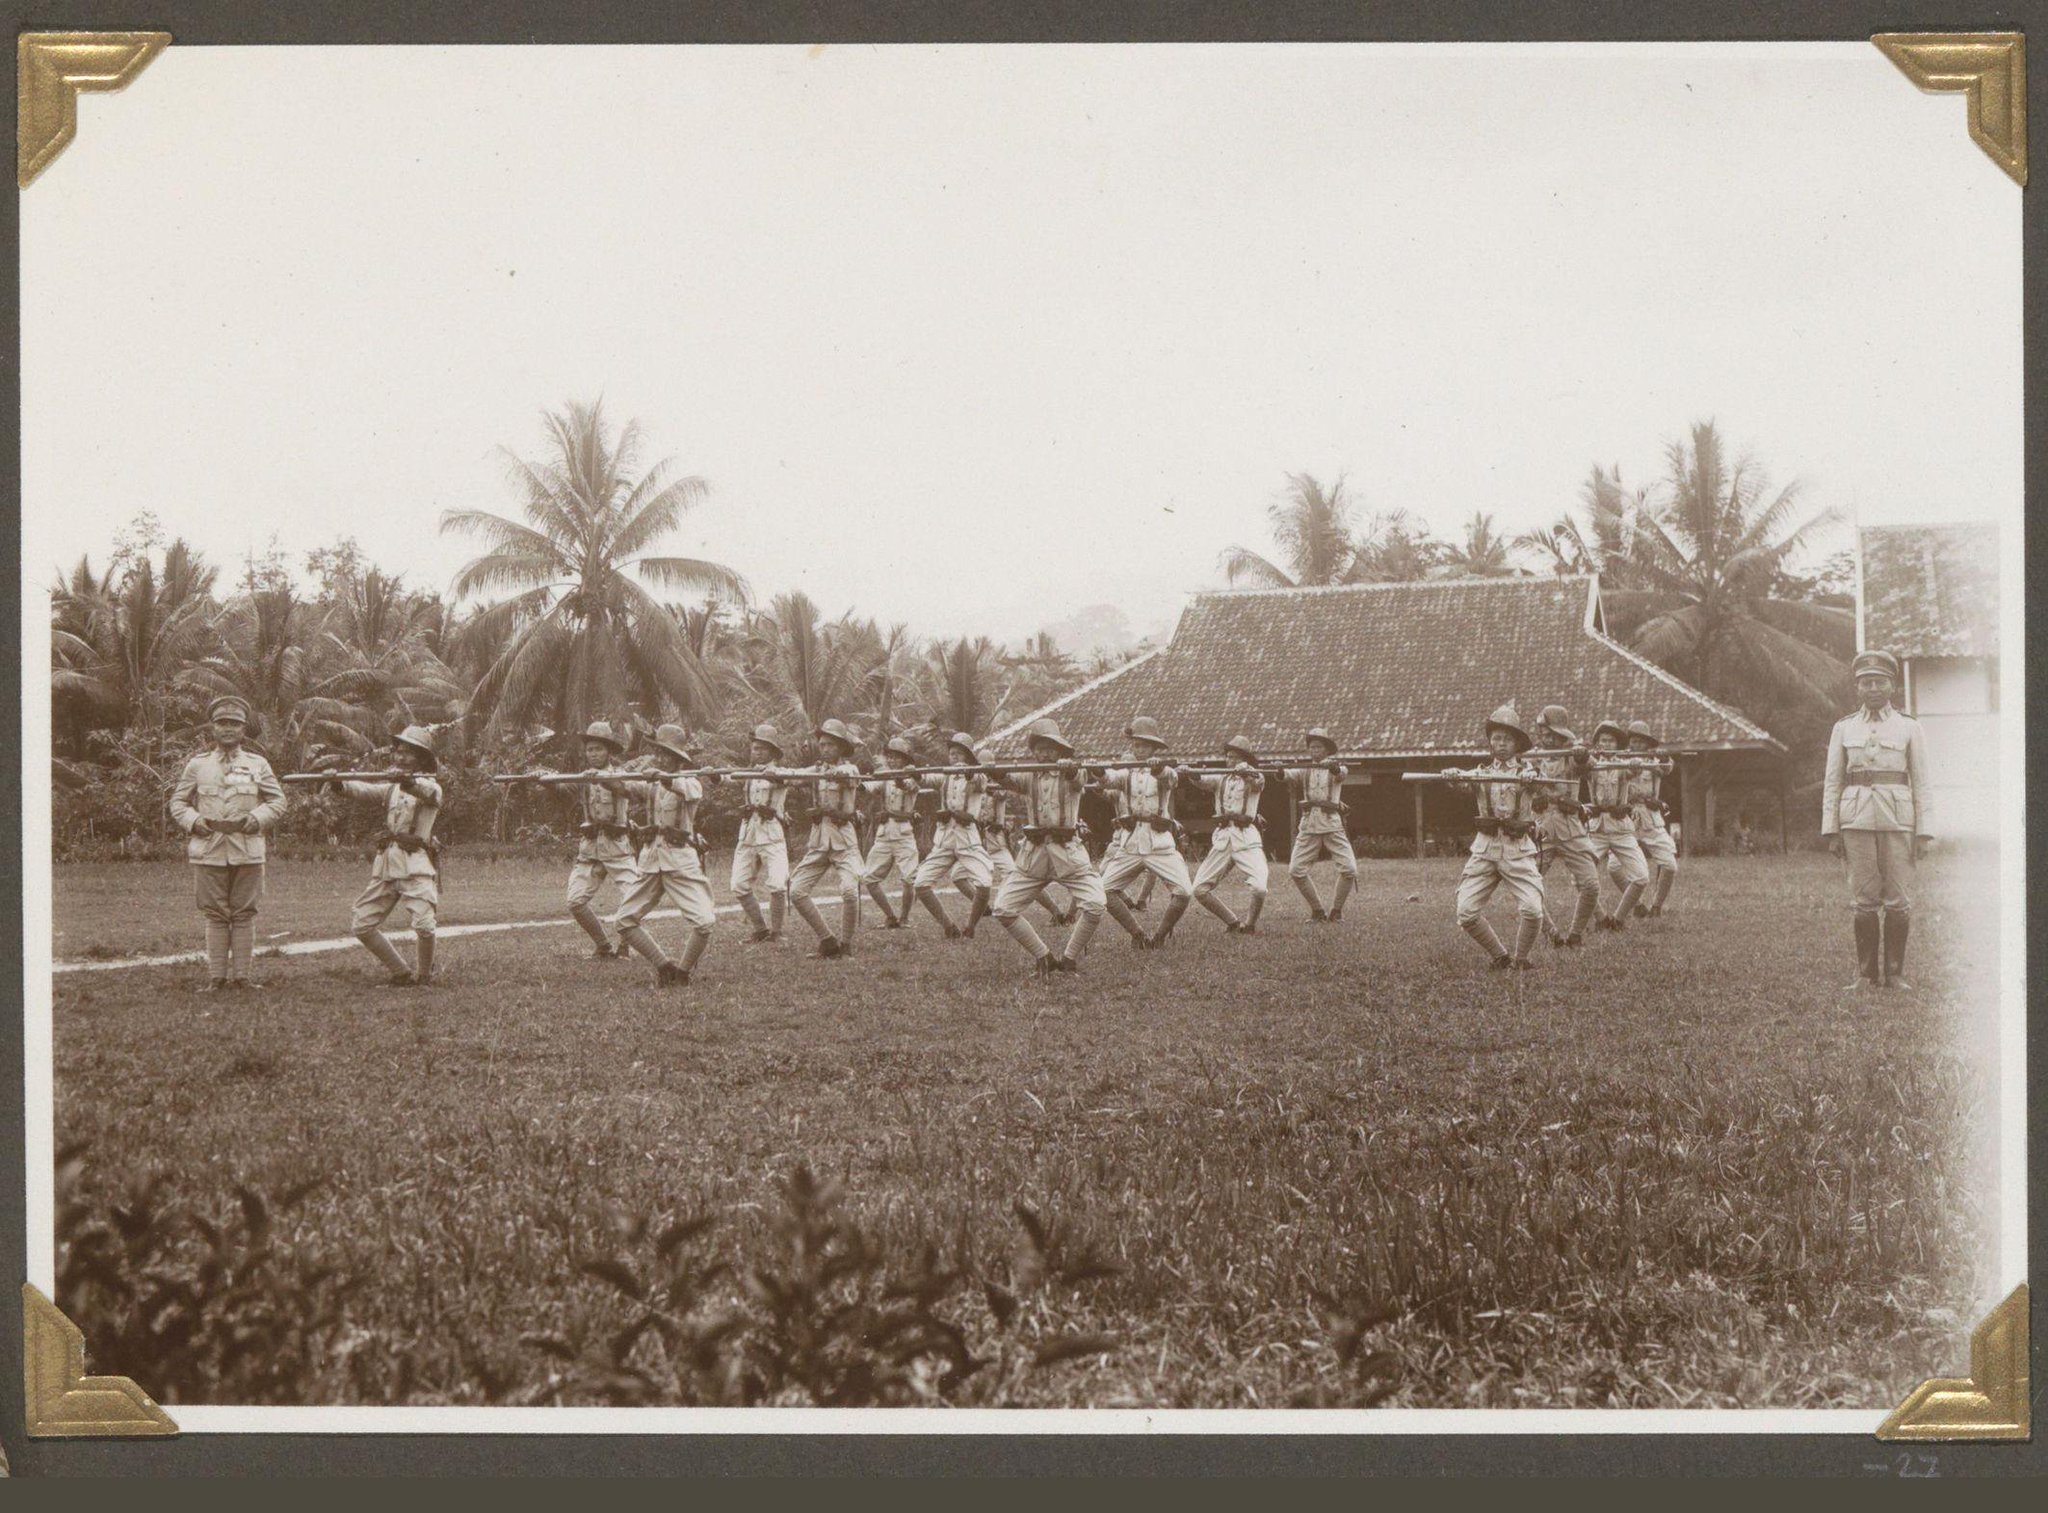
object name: photograph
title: Politieagenten doen gymnastiekoefeningen met karabijn in Lampong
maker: Anonymous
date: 1932-1933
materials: photographic support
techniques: gelatin silver print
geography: lampung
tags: gymnastic exercises on the ground, firearms, police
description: Onderdeel van Herinneringsalbum voor F.J. Junius, vertrekkend resident van Lampong (Zuid-Sumatra).